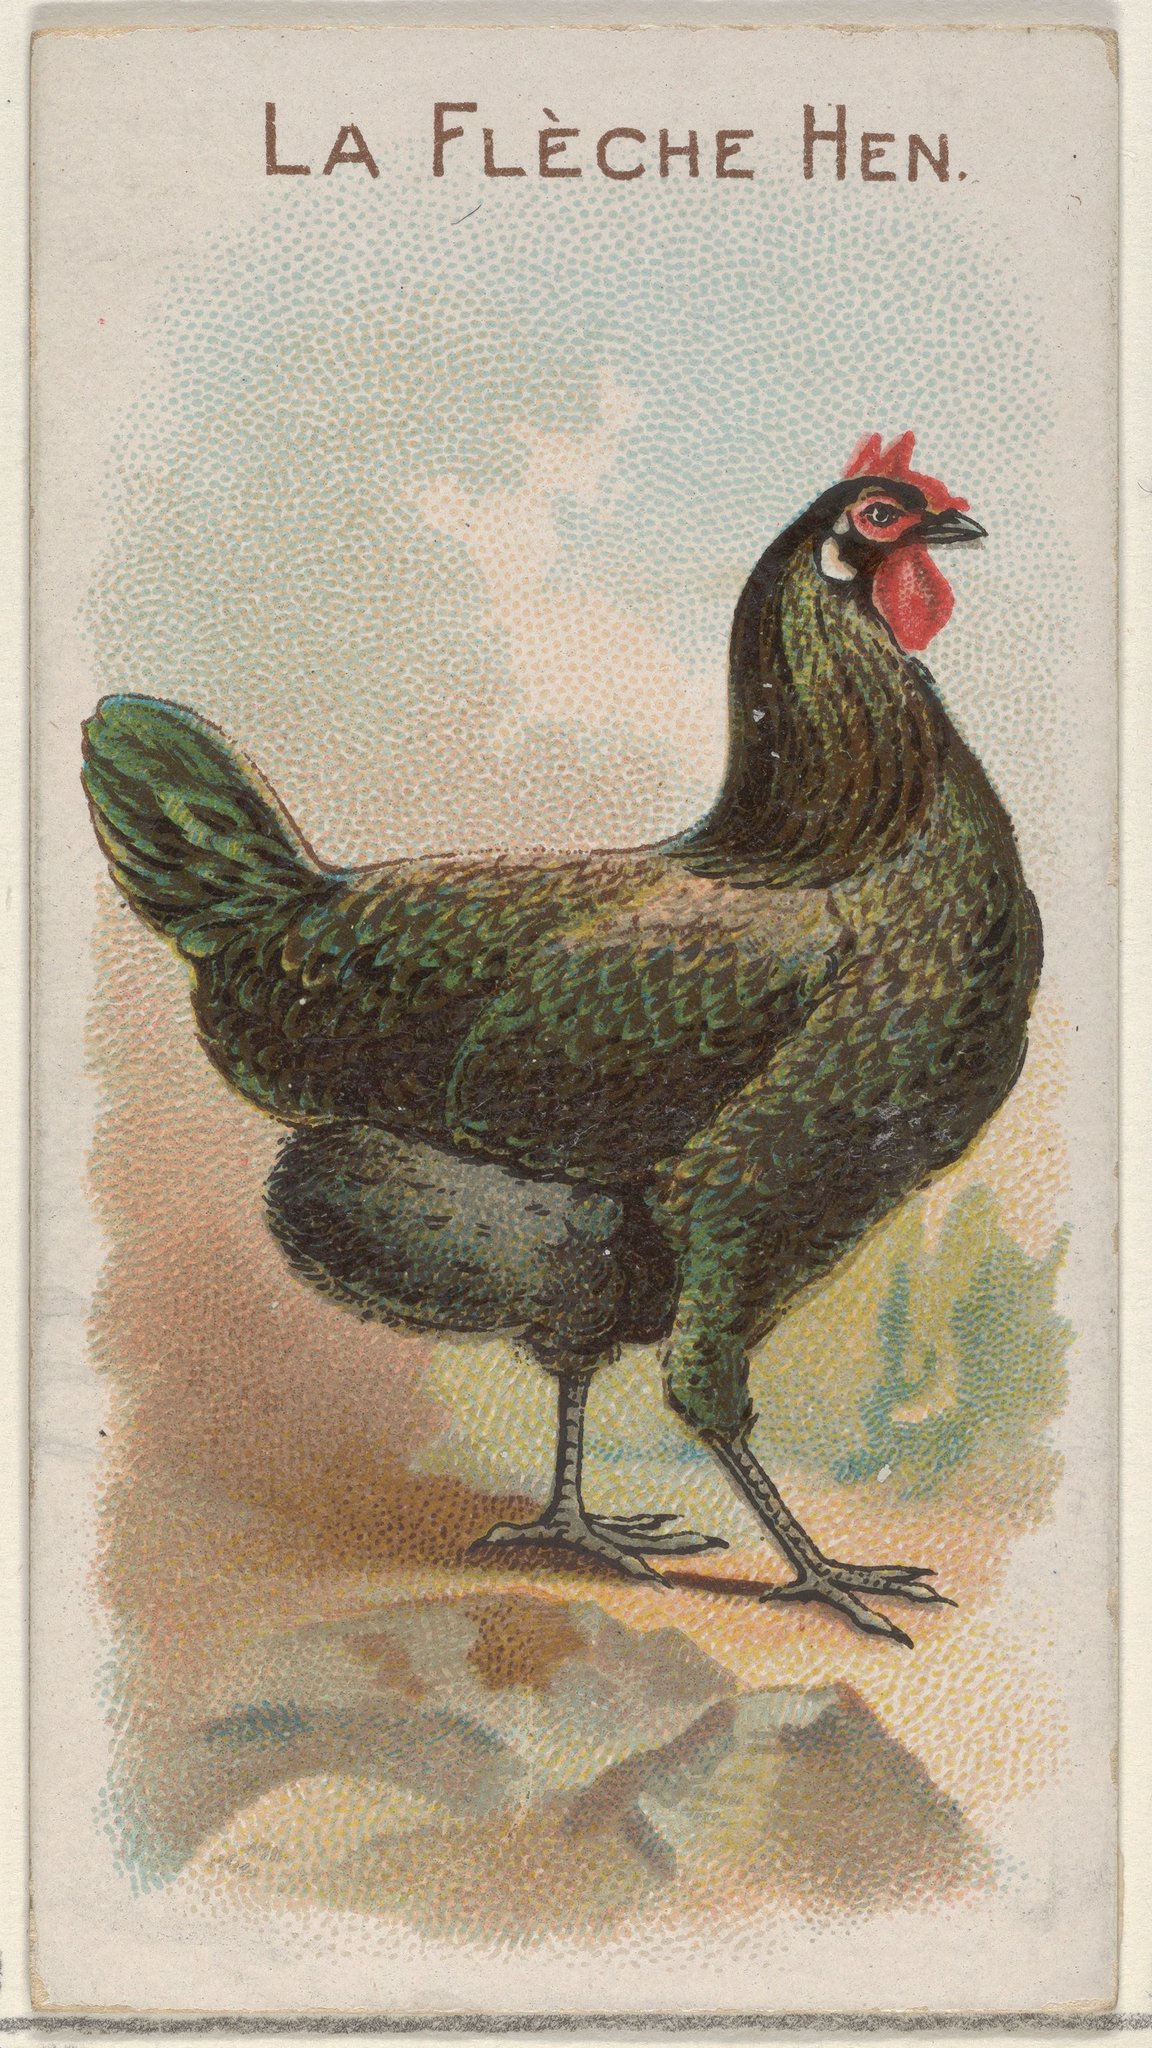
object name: print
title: La Flèche Hen, from the Prize and Game Chickens series (N20) for Allen & Ginter Cigarettes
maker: allen & ginter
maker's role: publisher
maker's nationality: american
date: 1891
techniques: color lithograph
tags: chickens